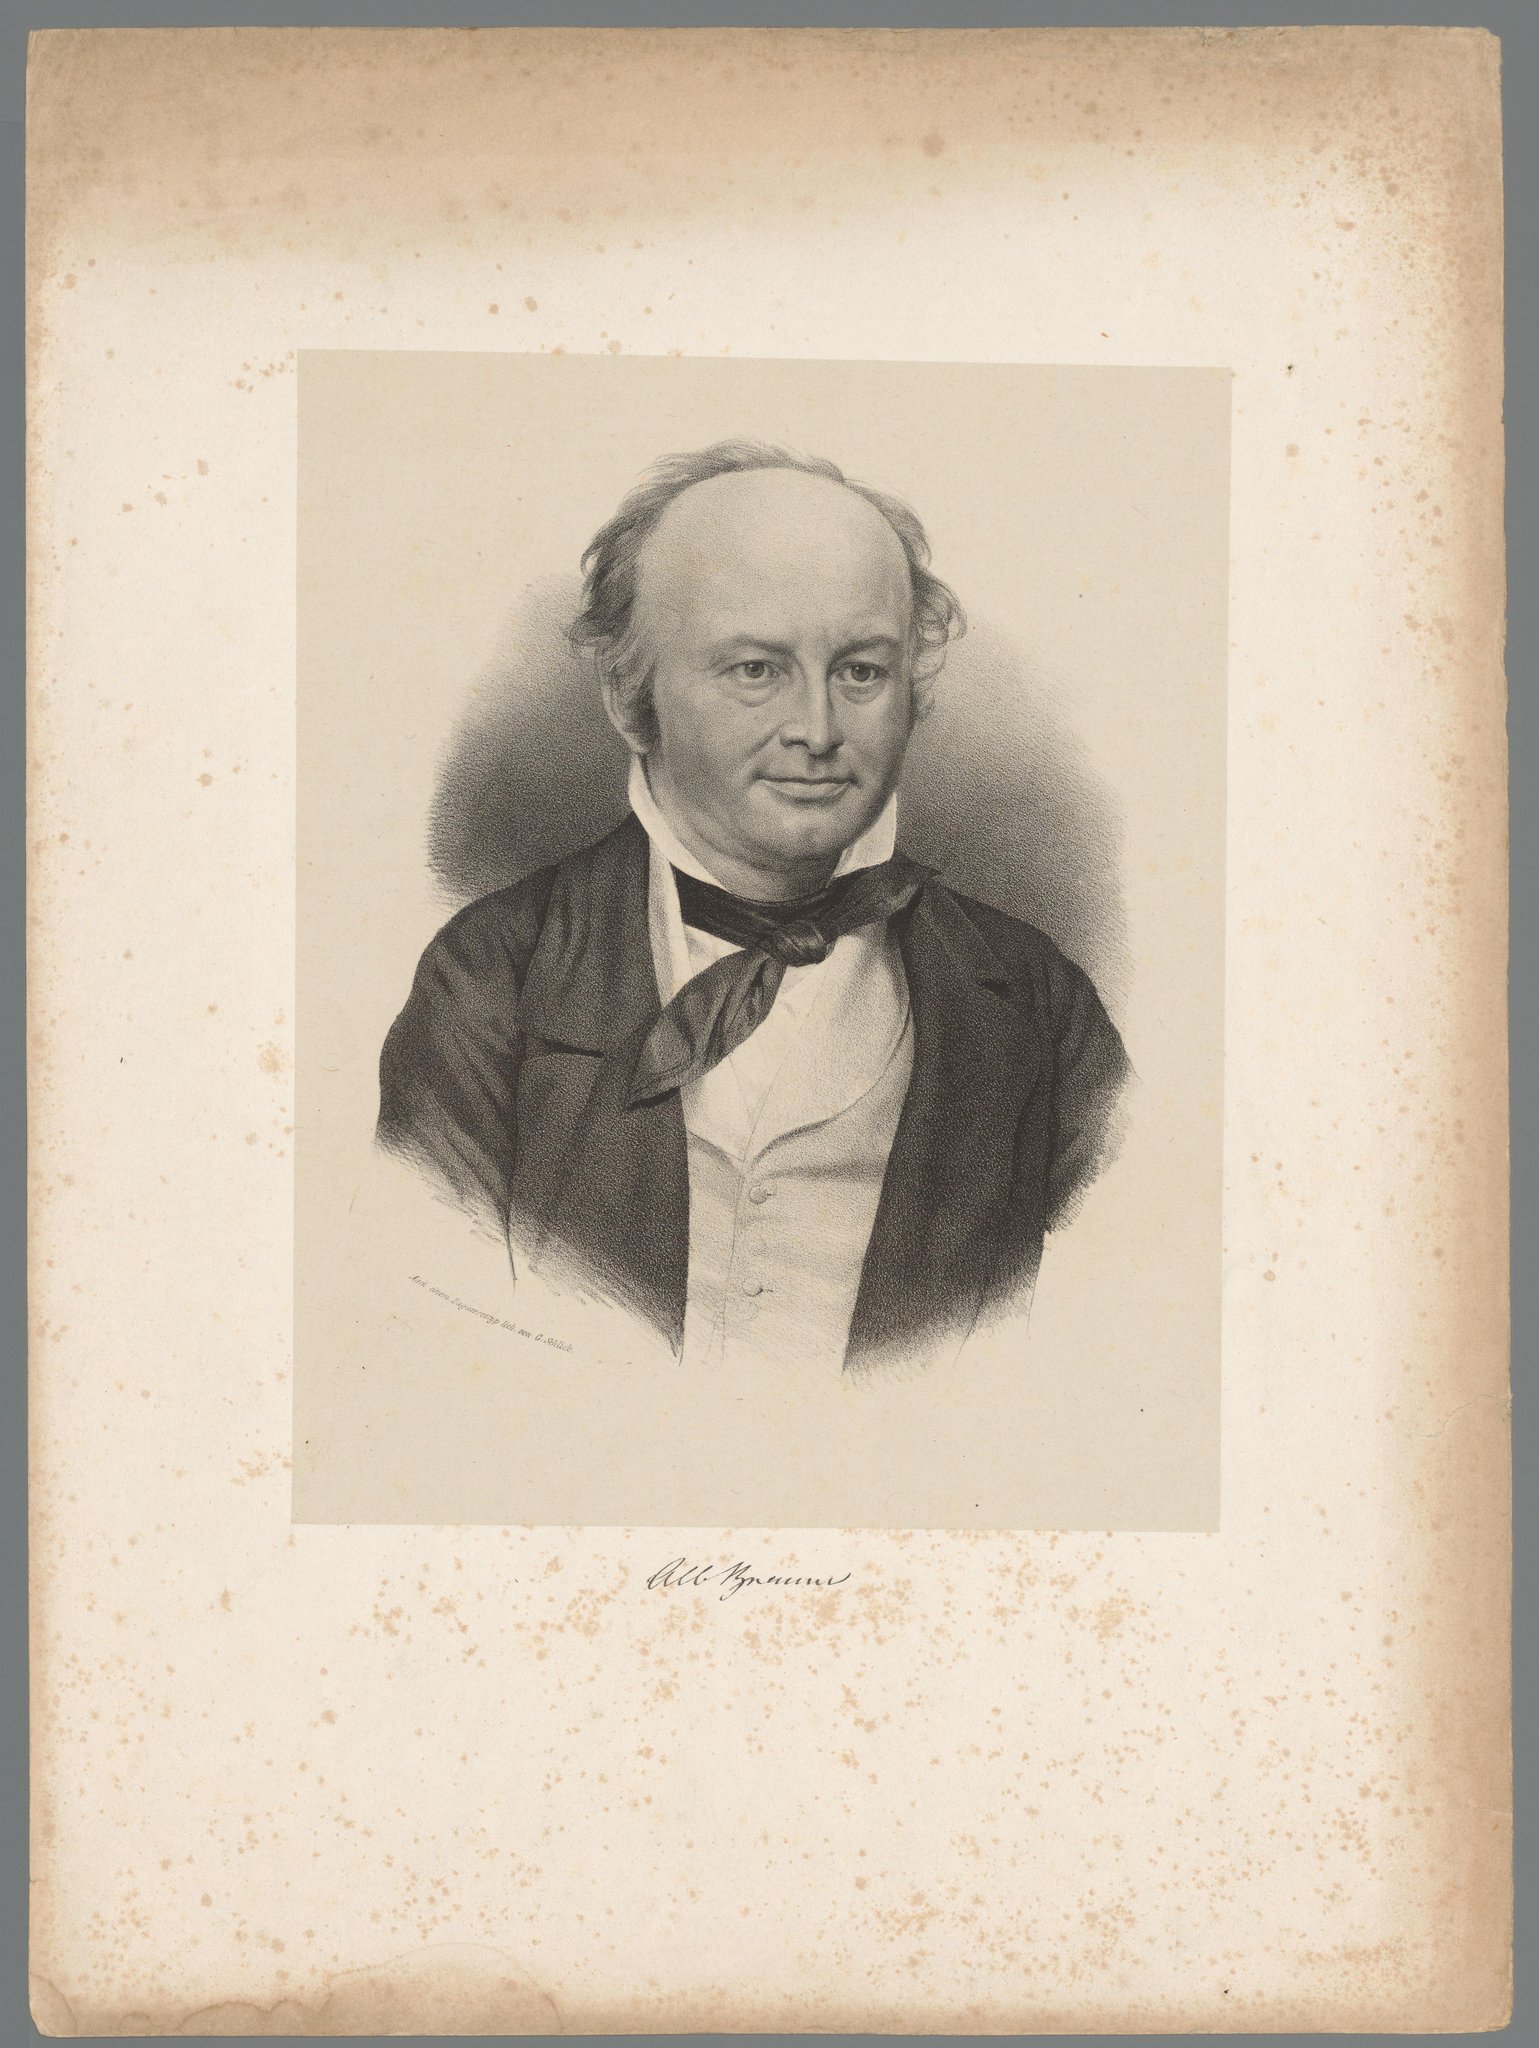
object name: print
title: Portret van Braun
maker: gustav schlick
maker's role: print maker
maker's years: 1804-1869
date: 1814-1869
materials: paper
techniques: lithograph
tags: historical persons not known by name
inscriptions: collector's mark: Lugt 2228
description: Portret van een verder onbekende man, met handtekening in facsimile waarin de naam Alb. Braun te lezen is.